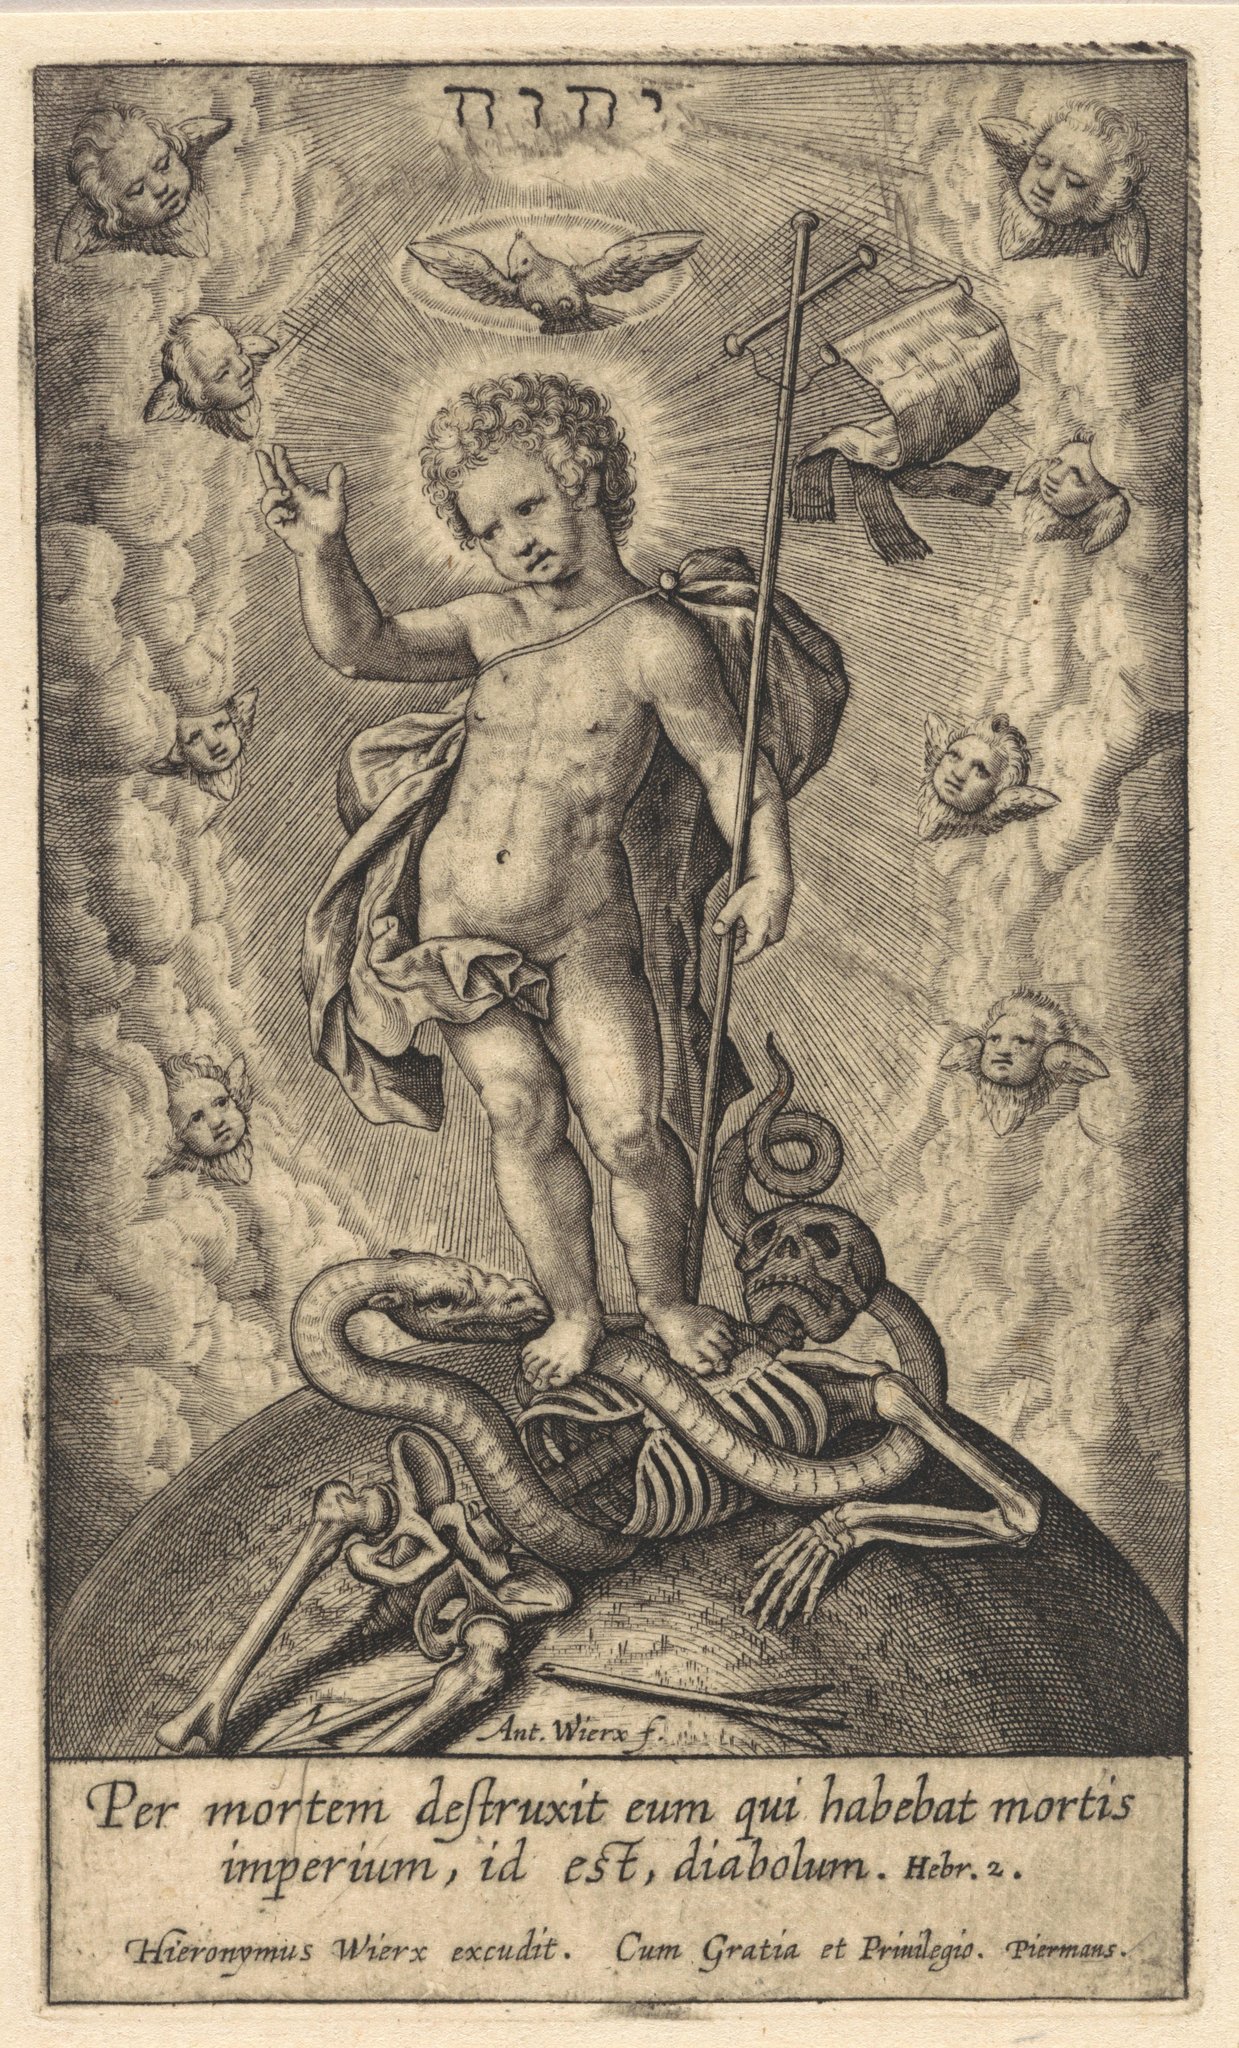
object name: print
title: Christuskind overwint de Dood en de duivel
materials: paper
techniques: engraving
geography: antwerp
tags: christ steps on devil(s), death as skeleton, christ triumphing (with crown, head usually upright), tetragram (in roman or hebrew script) ~ symbol of god the father, holy ghost represented as a dove (in flames)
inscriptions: collector's mark: Lugt 2228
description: Het triomferende Christuskind overwint de Dood en de duivel. Hij staat op een globe en vertrapt een skelet en een slang. Boven zijn hoofd de Heilige Geest in de gedaante van een duif en een tetragram, het symbool voor God de Vader. Hij is omringd door wolken met cherubijnen. In de marge een tweeregelig Bijbelcitaat uit Heb. 2 in het Latijn.